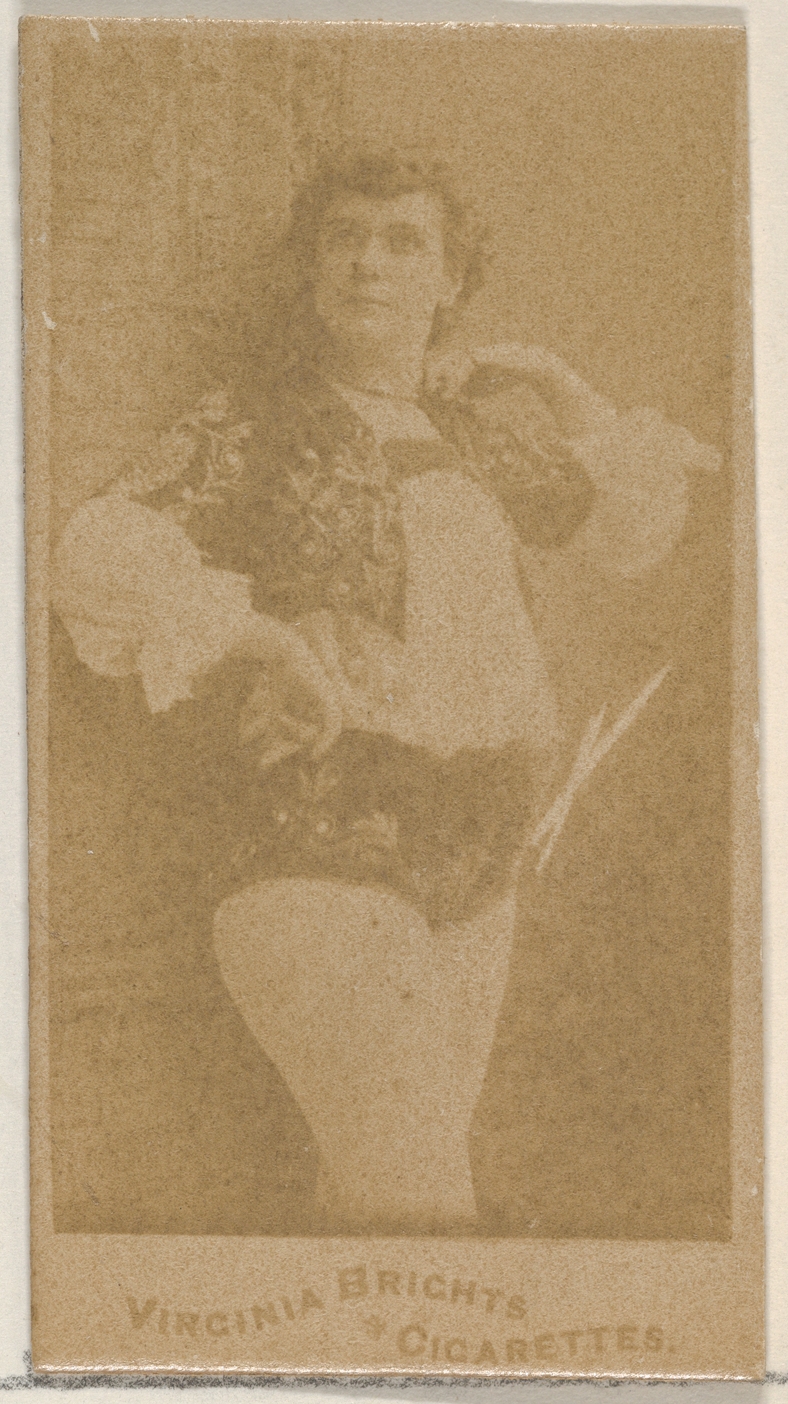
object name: photograph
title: From the Actors and Actresses series (N45, Type 5) for Virginia Brights Cigarettes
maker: allen & ginter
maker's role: publisher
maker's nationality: american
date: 1888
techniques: albumen silver print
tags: portraits,women